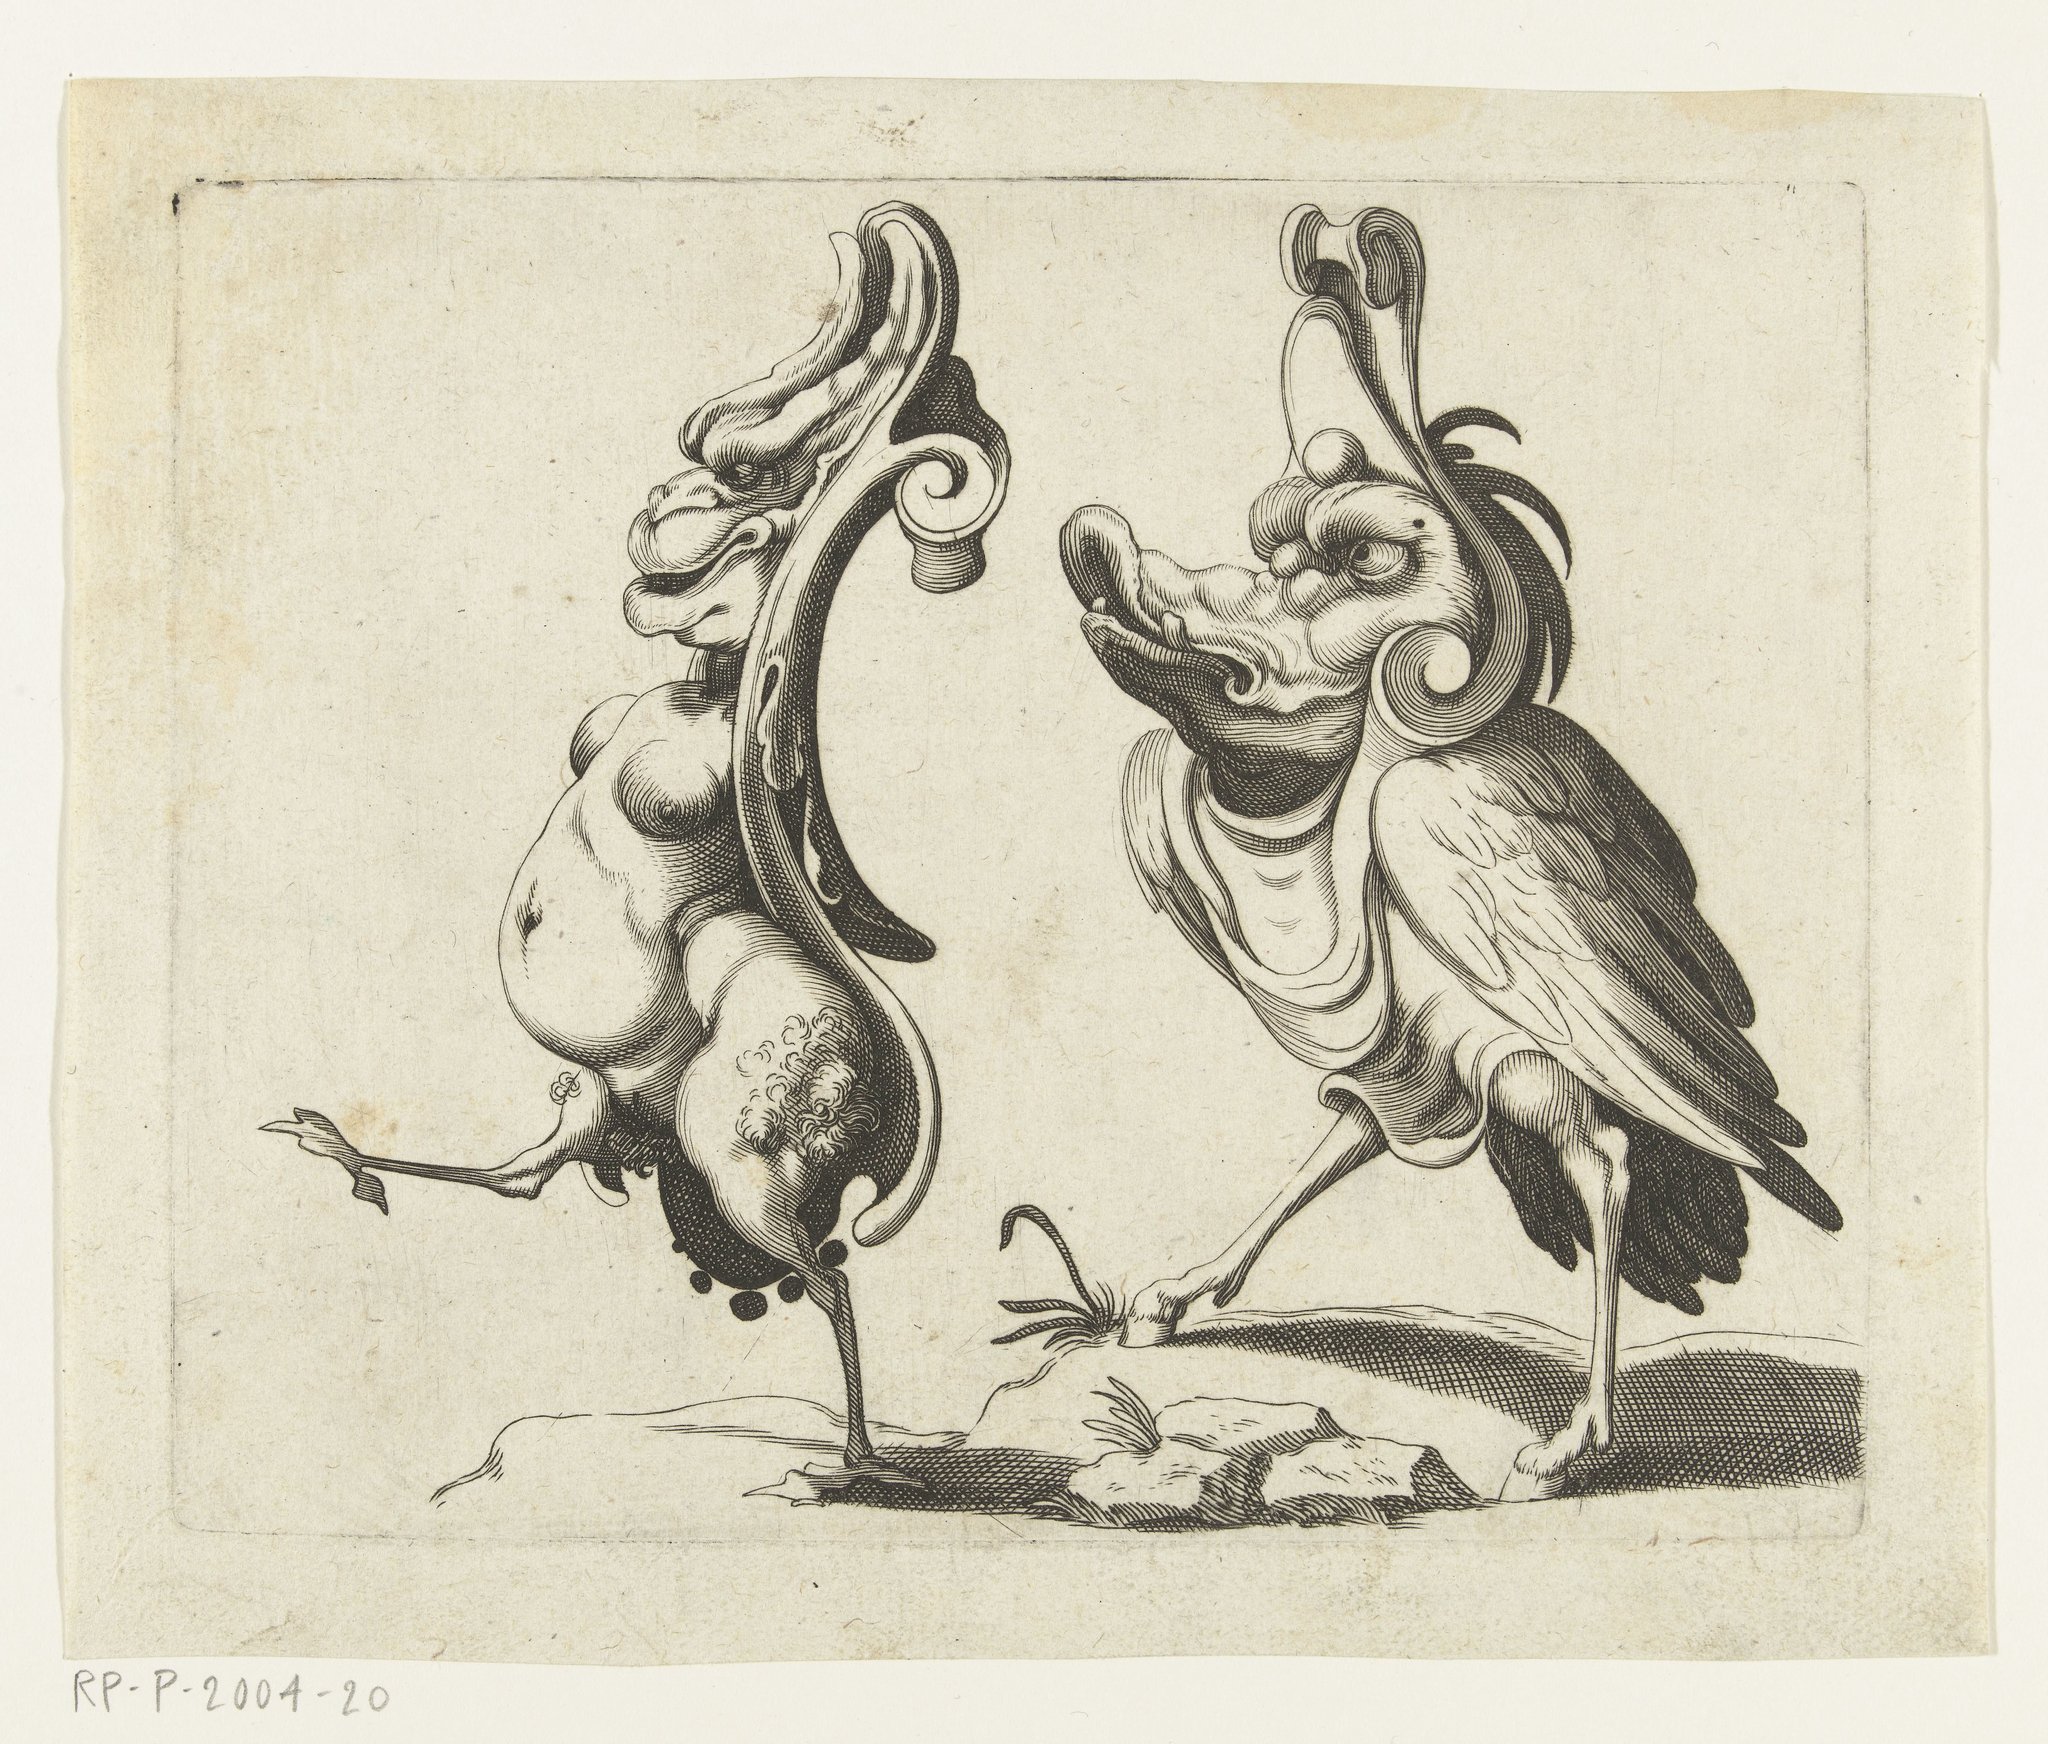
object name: print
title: Twee grotesken, naar links lopend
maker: Anonymous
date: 1600-1625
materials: paper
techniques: engraving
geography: netherlands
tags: ornament ~ grotesque, fabulous animals (sometimes wrongly called 'grotesques'); 'mostri' (ripa)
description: Twee grotesken, naar links lopend. De voorste heeft vogelpoten, de achterste hoeven. Uit serie van 12.